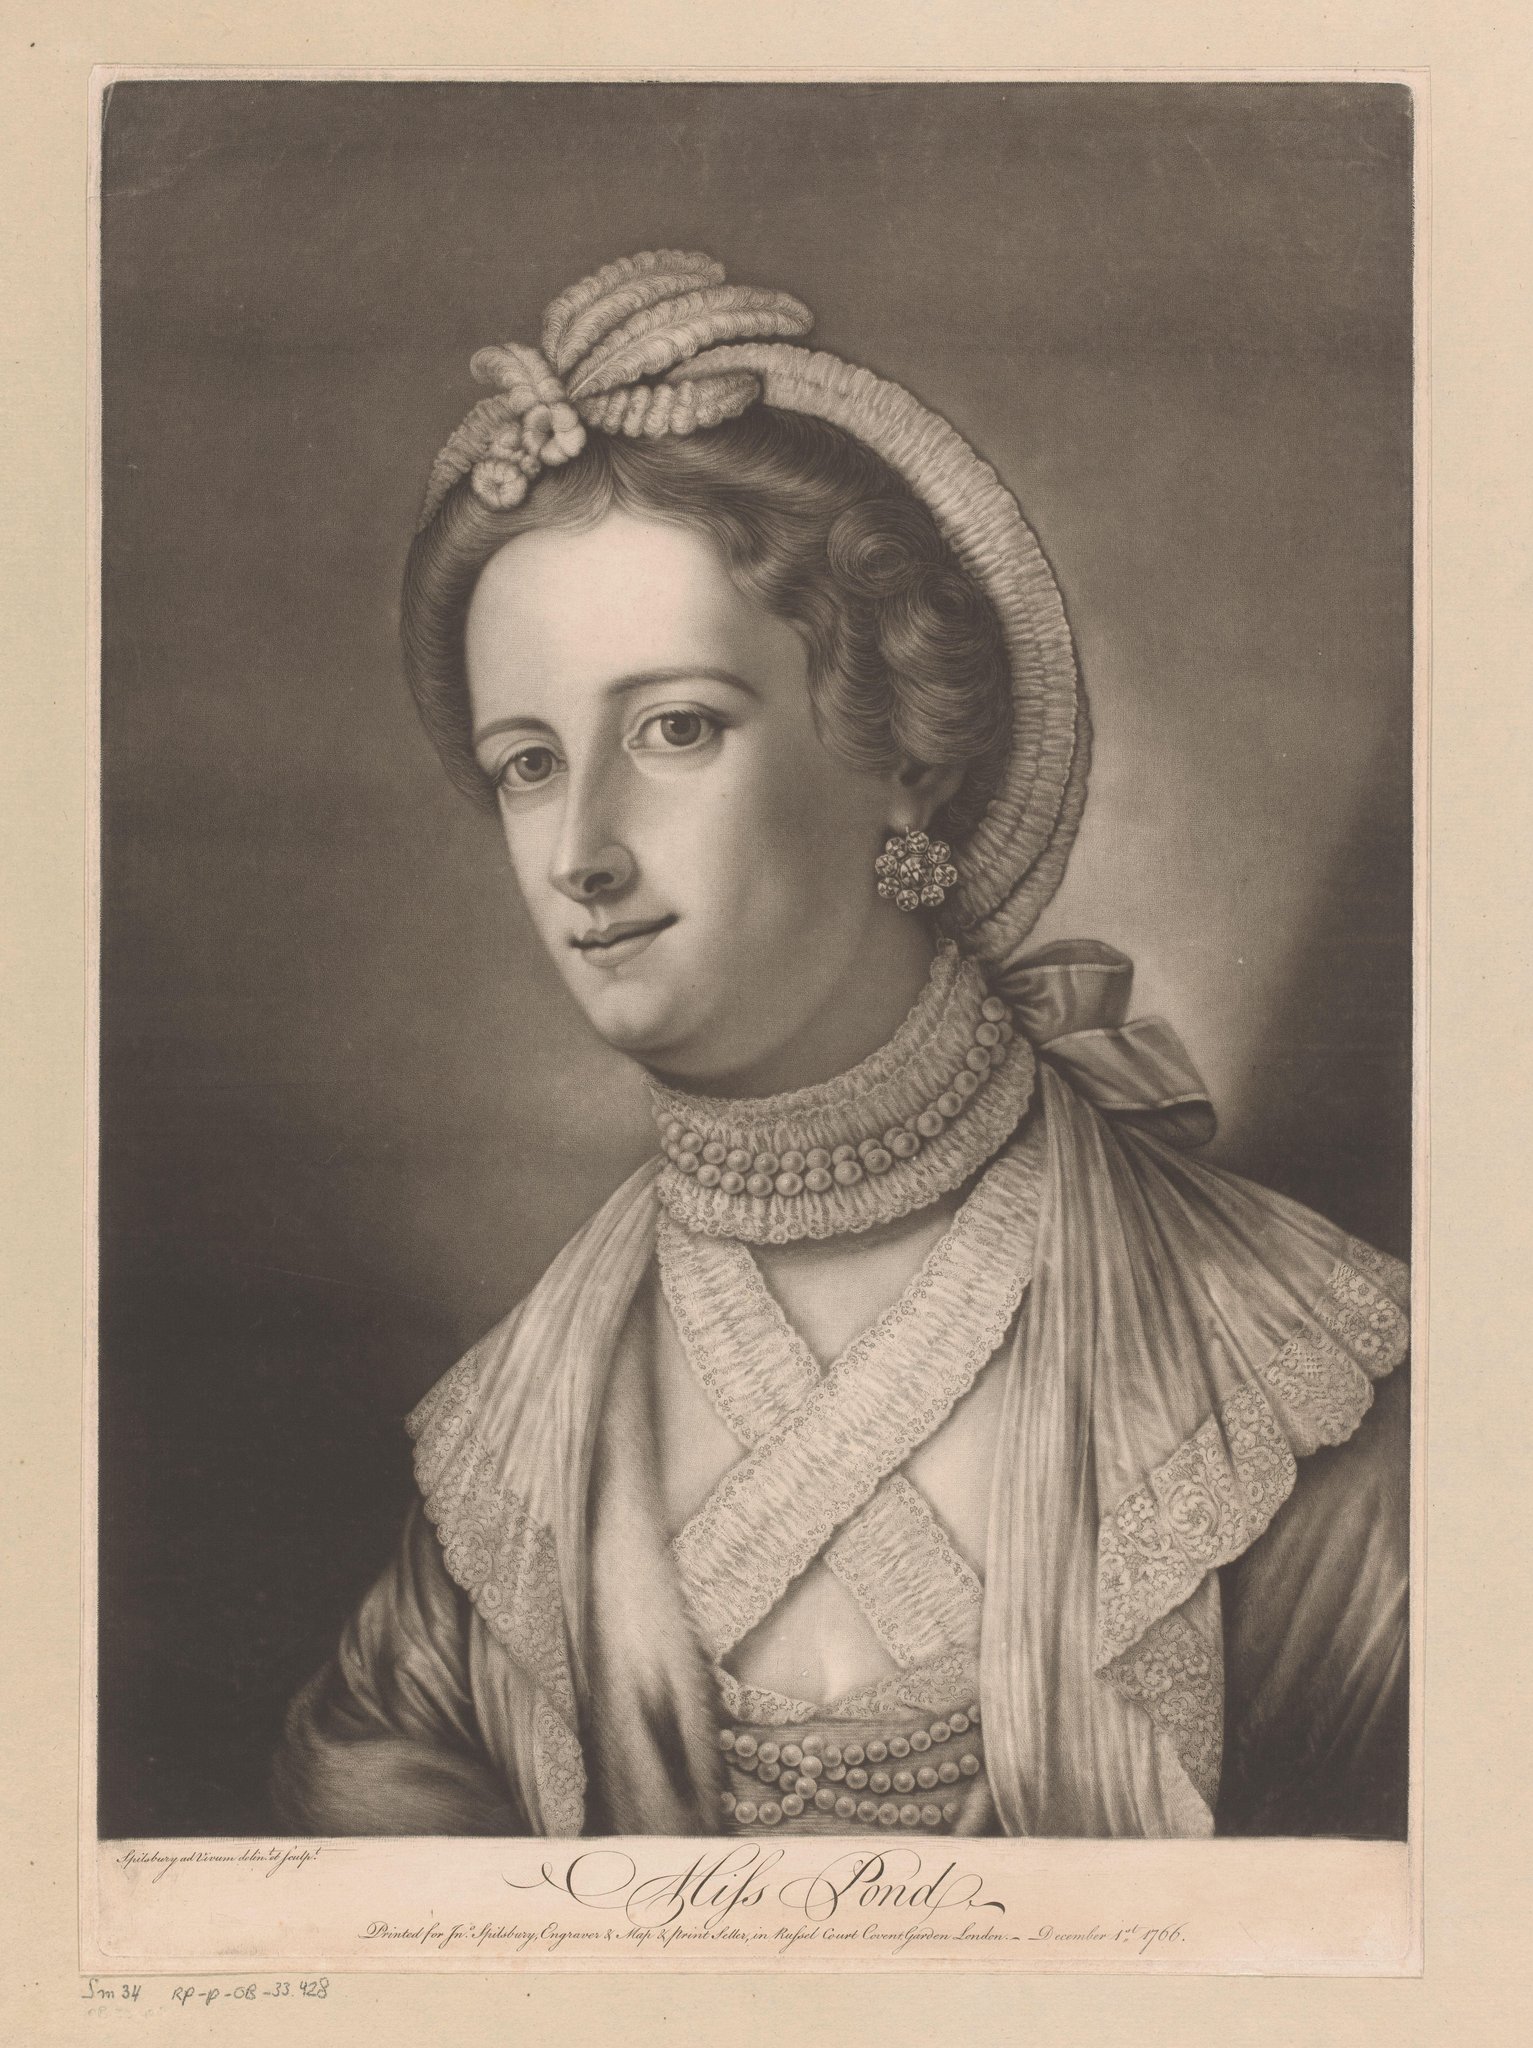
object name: print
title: Portret van mevrouw Pond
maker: jonathan spilsbury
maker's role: print maker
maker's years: 1737-1812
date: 1712-1766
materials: paper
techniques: etching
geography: london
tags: historical persons - bb - woman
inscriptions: collector's mark: Lugt 240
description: Mogelijk een kleindochter of nicht van Arthur Pond, zie exemplaar in British Museum en Russell, 1926.